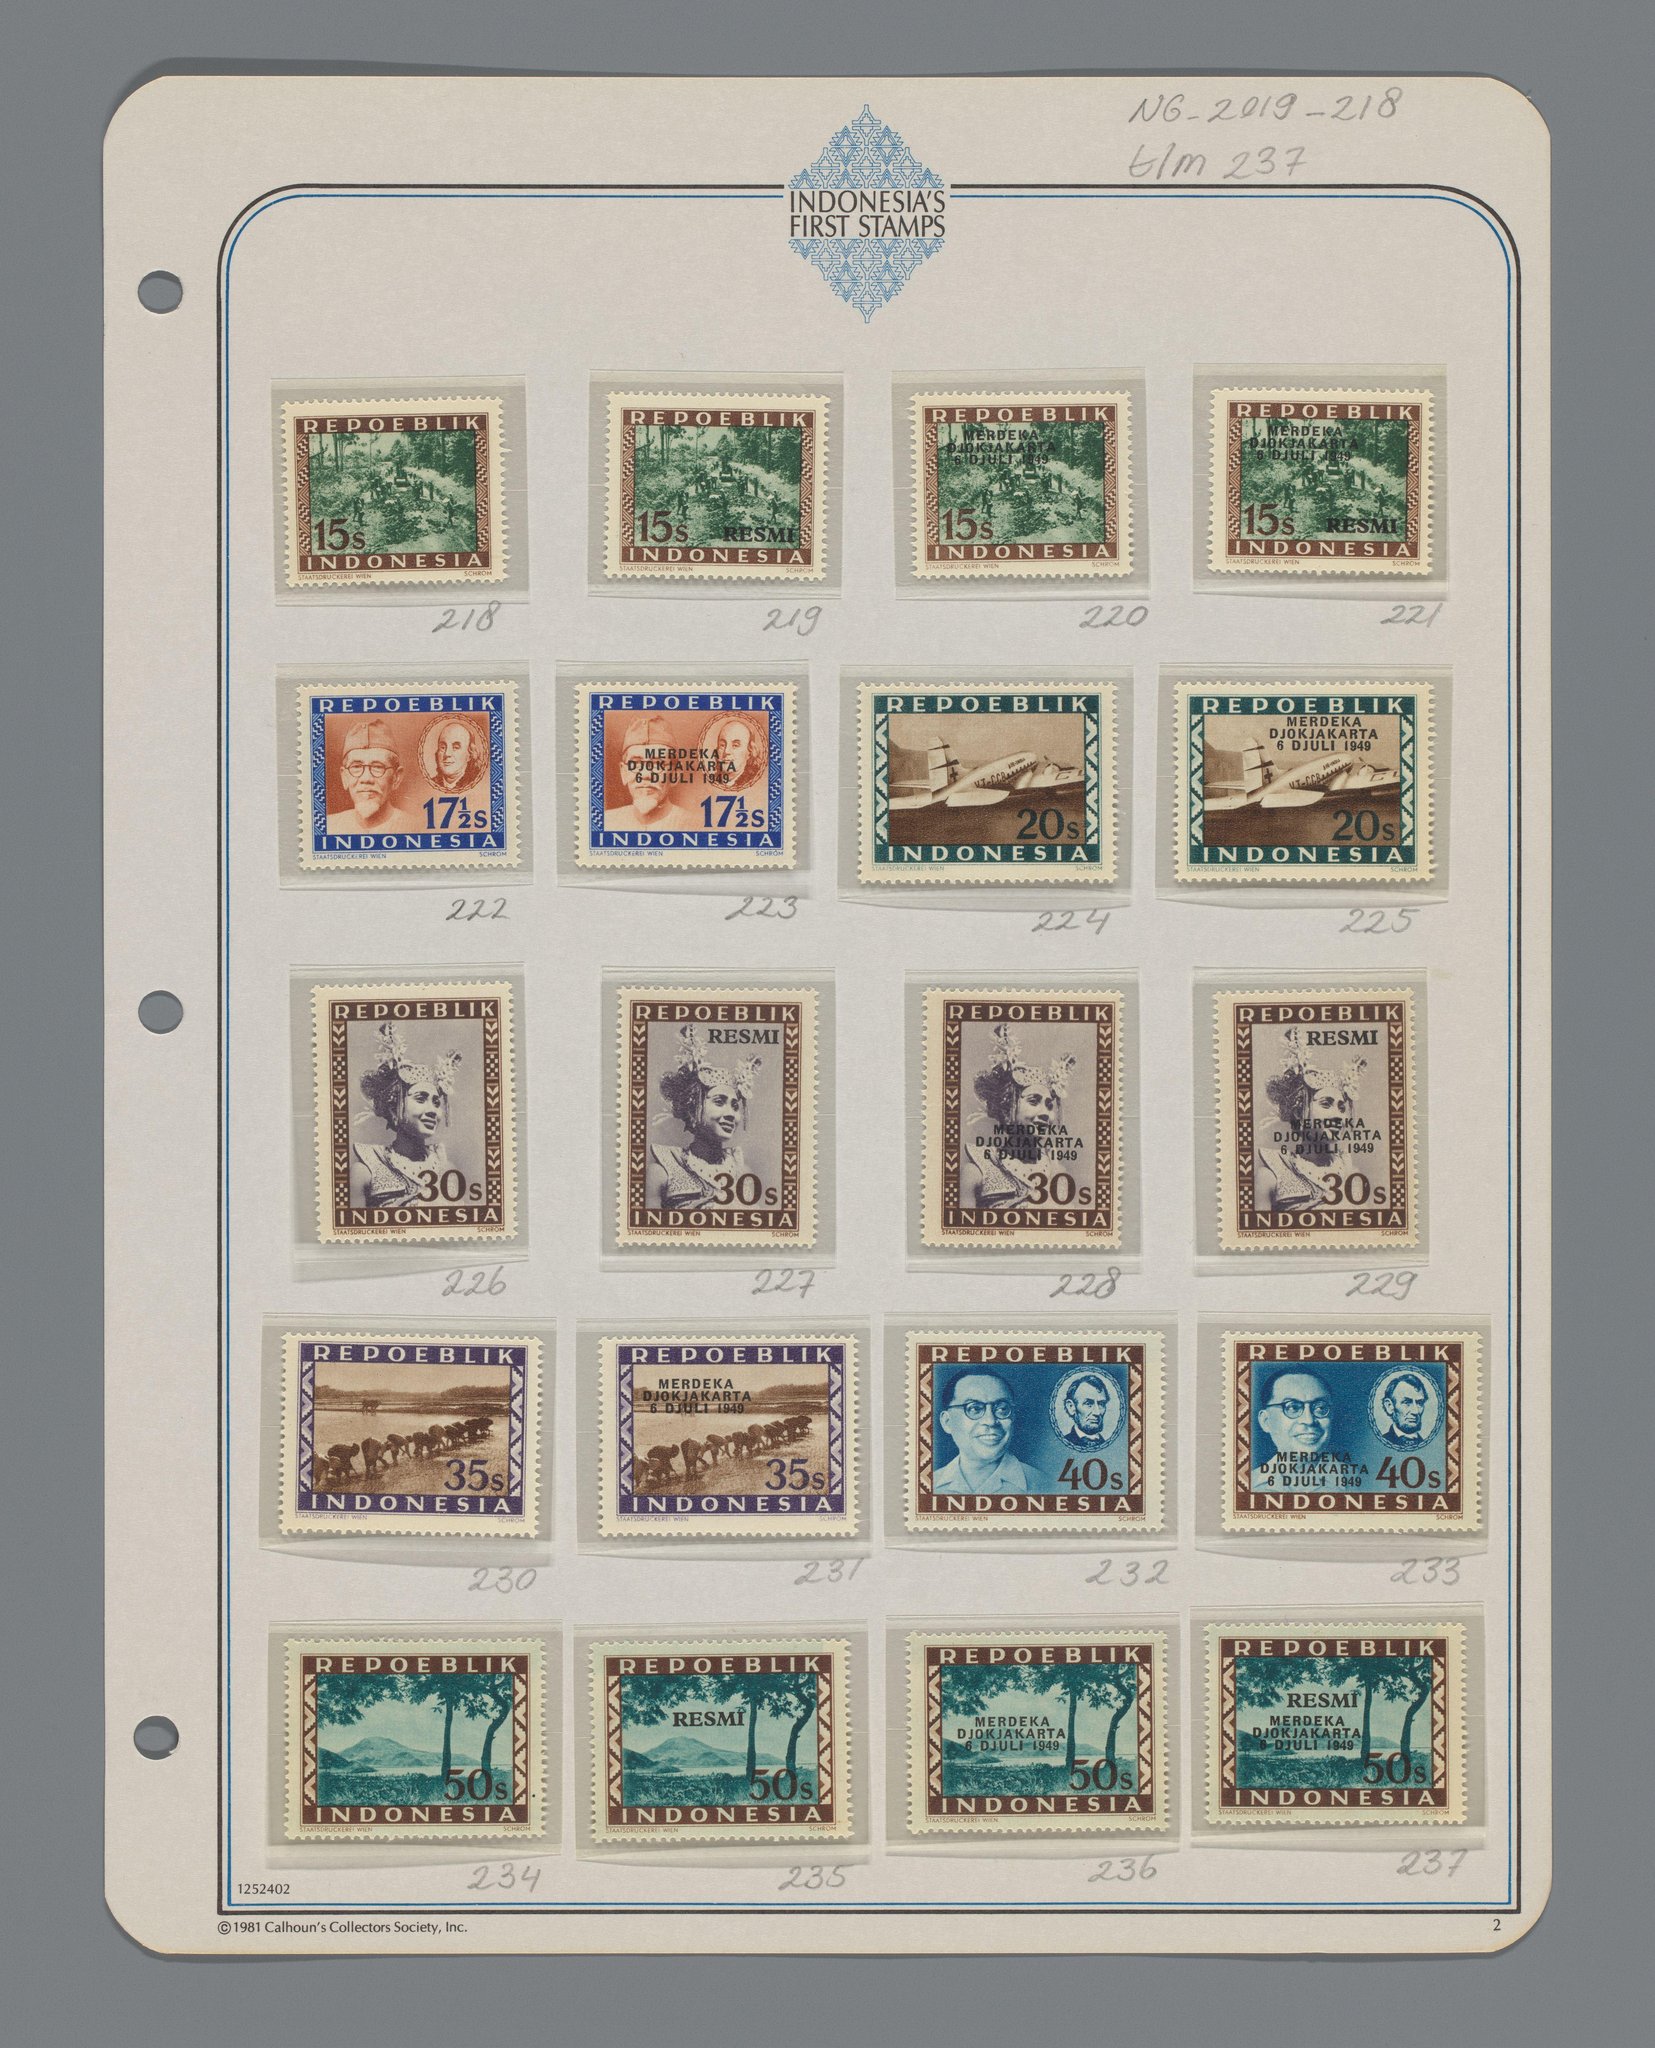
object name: postage stamp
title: Postzegel Republik Indonesia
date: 1949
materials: paper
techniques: photoaquatint, engraving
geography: philadelphia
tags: indonesia